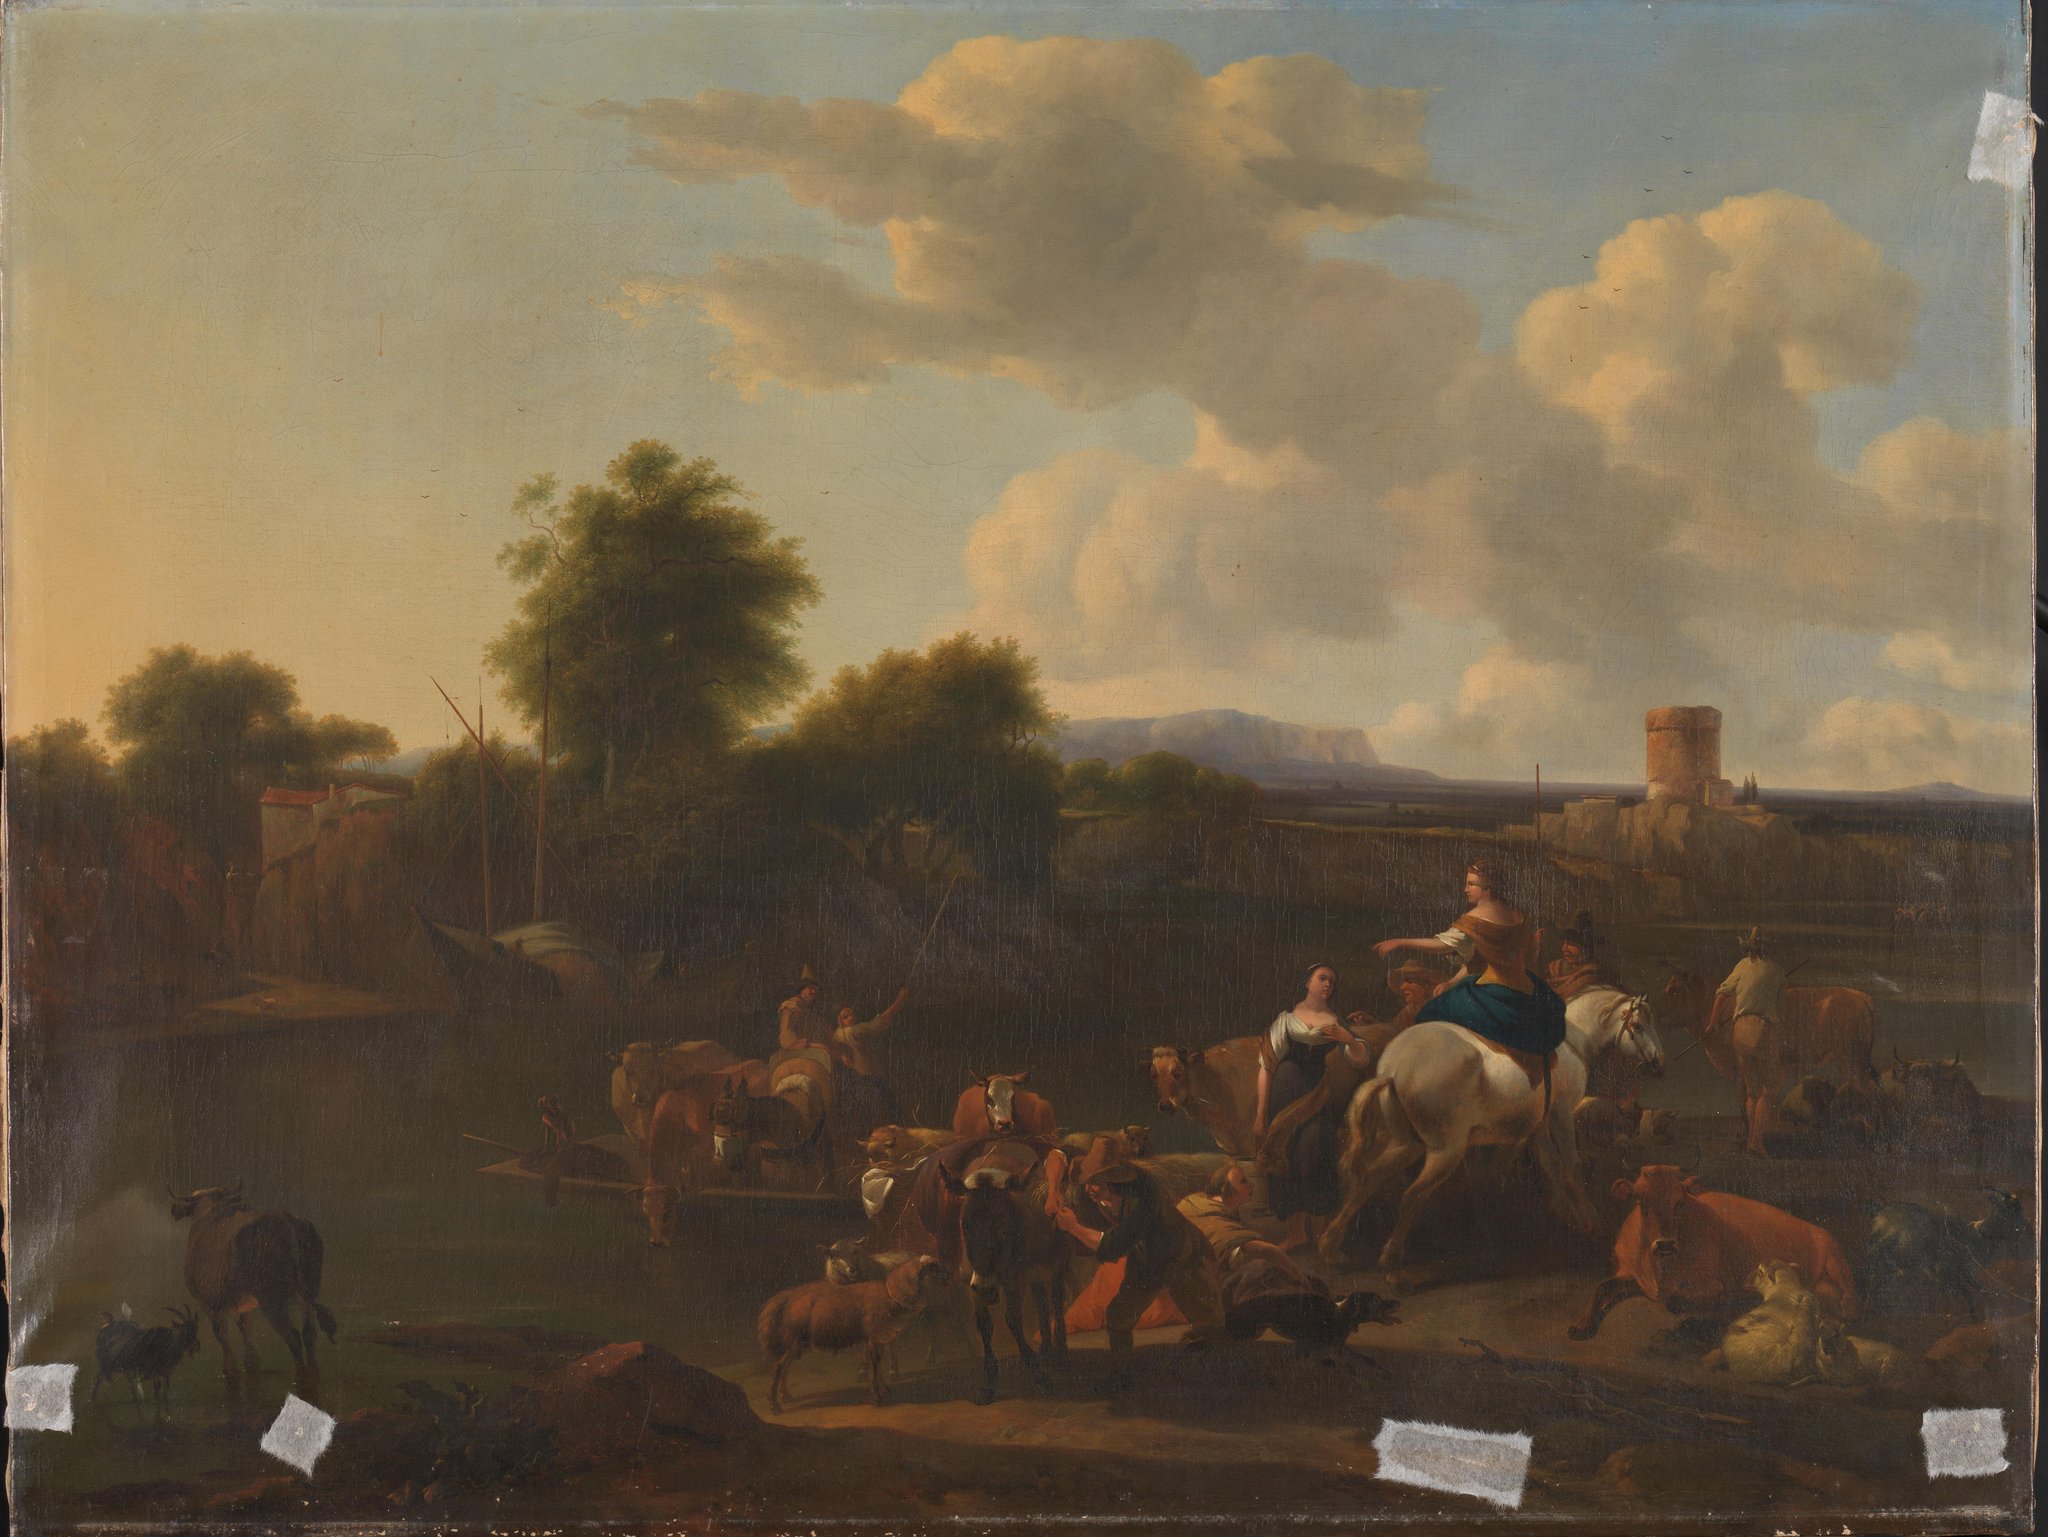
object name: painting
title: The Cattle Ferry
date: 1700-1799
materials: canvas, oil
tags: cow, river, herding, herdsman, herdswoman, shepherd, shepherdess, cowherd, etc., ferry, sheep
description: Het ponteveer. Kopie naar het schilderij van Berchem, SK-A-31. Op de voorgrond wachten herders met hun kuddes koeien en schapen en een vrouw op een paard op de pont om de rivier mee over te steken.